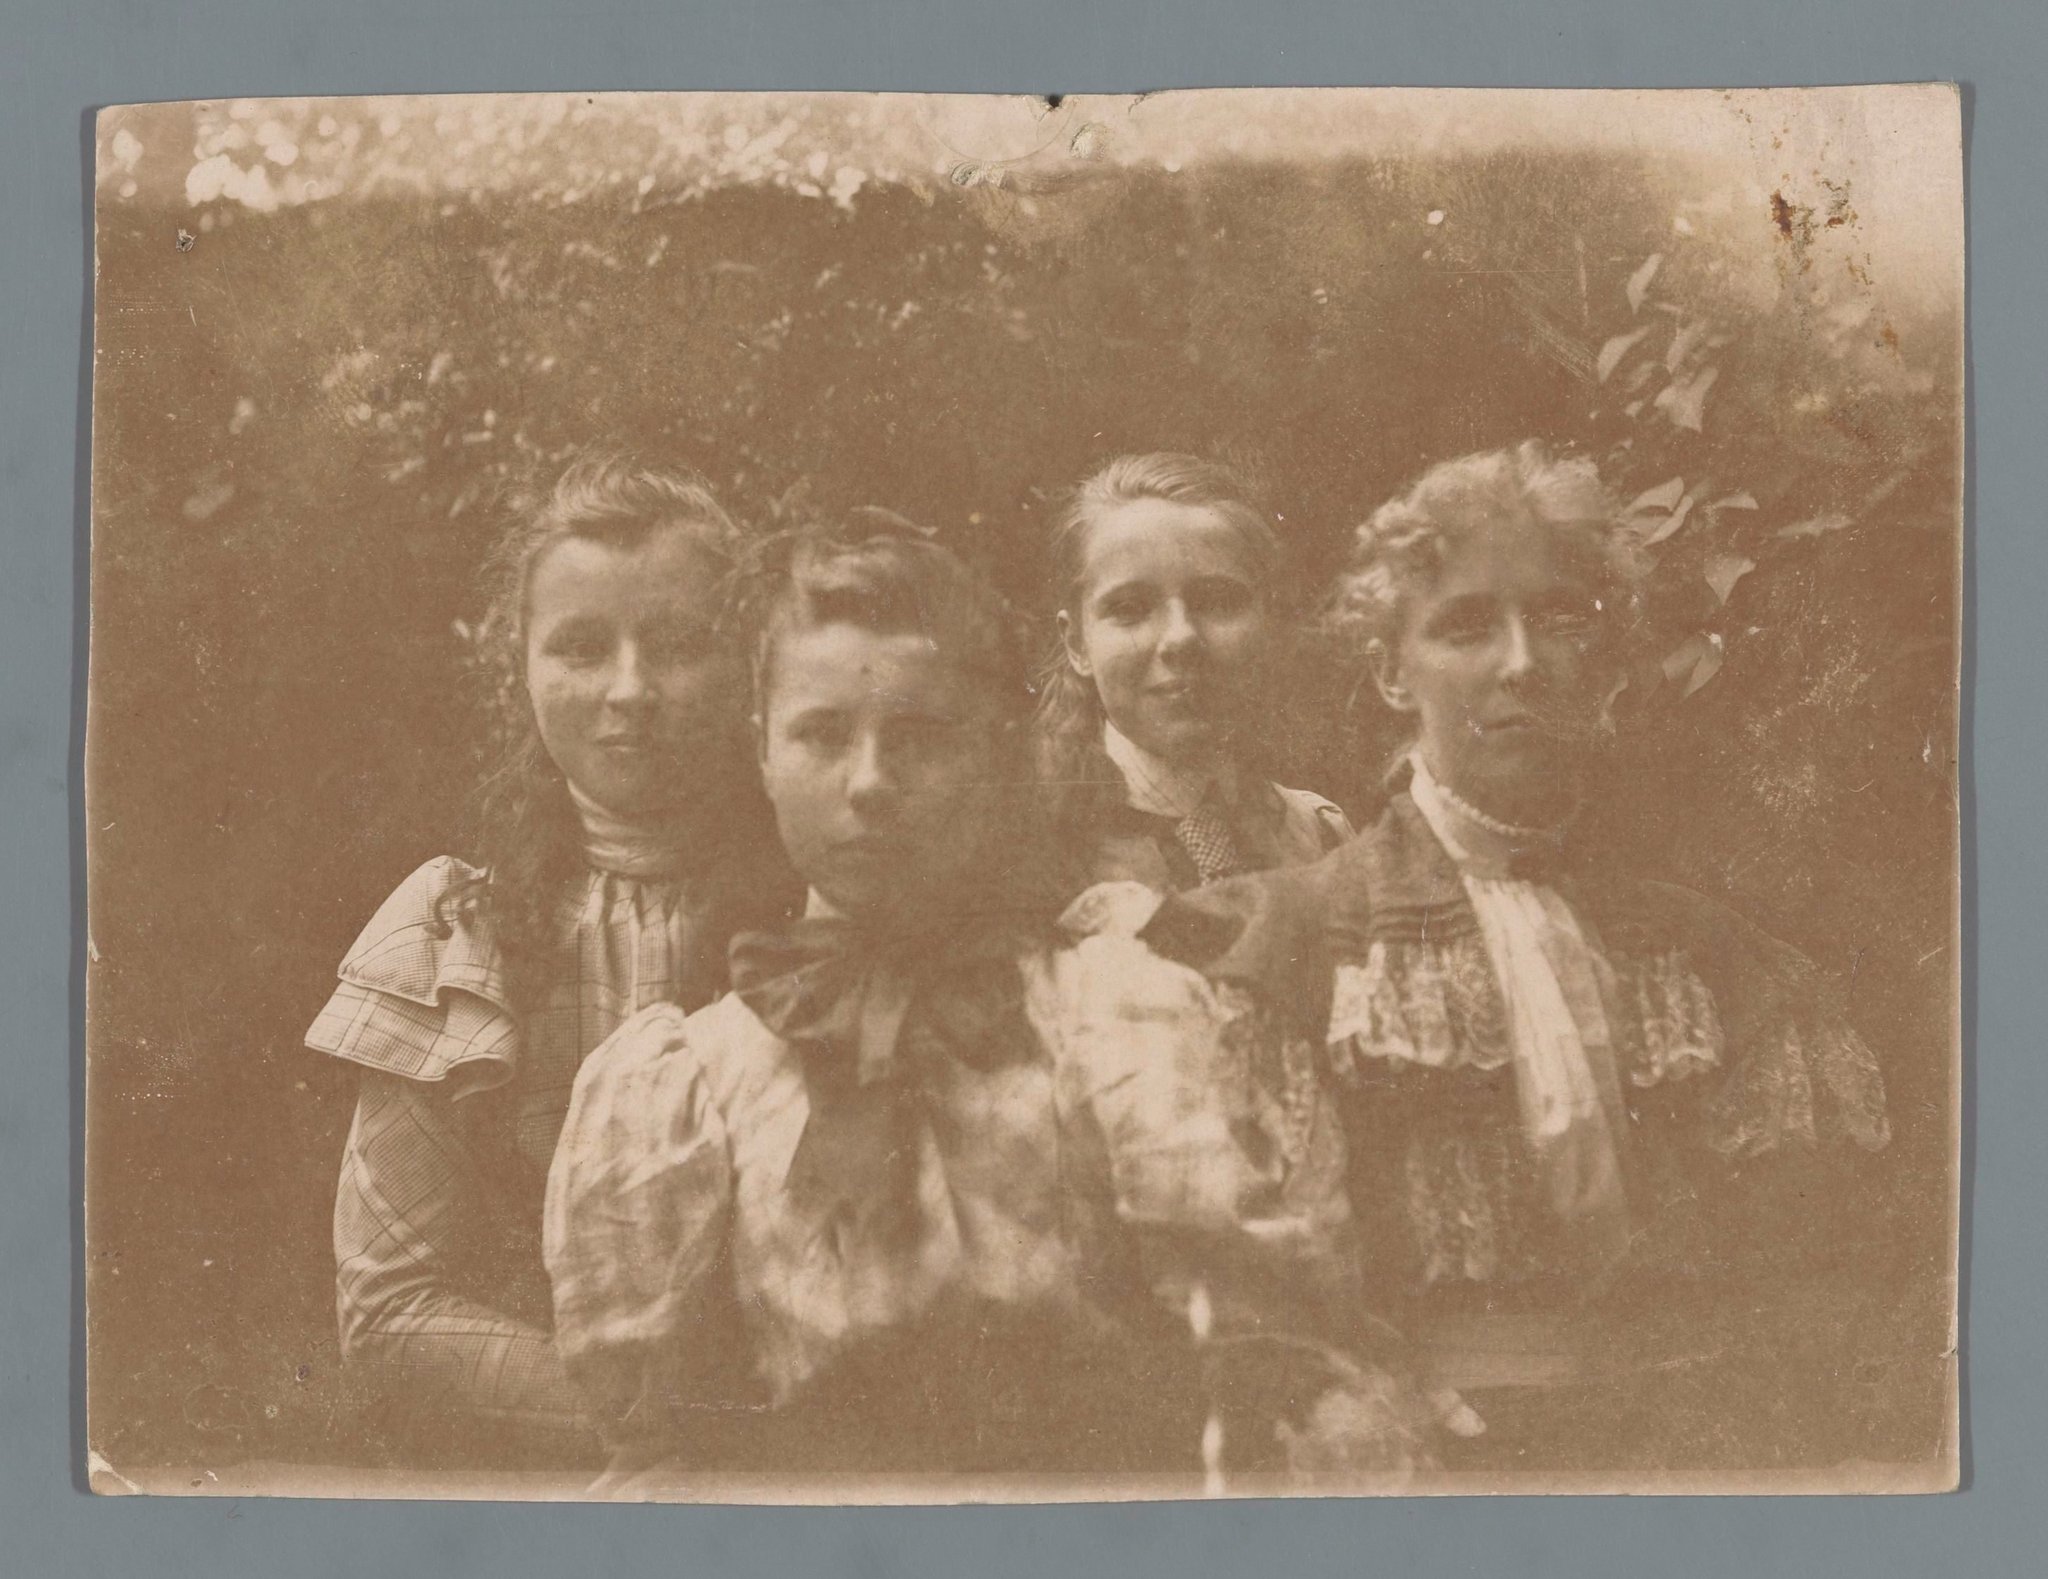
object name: photograph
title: Portret van vier meisjes in een tuin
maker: Anonymous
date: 1899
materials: photographic support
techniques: gelatin silver print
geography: netherlands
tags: garden, girl (child between toddler and youth)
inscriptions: inscription: ‘Dag Anna Ann Betsy B[...] 12 April 1899’